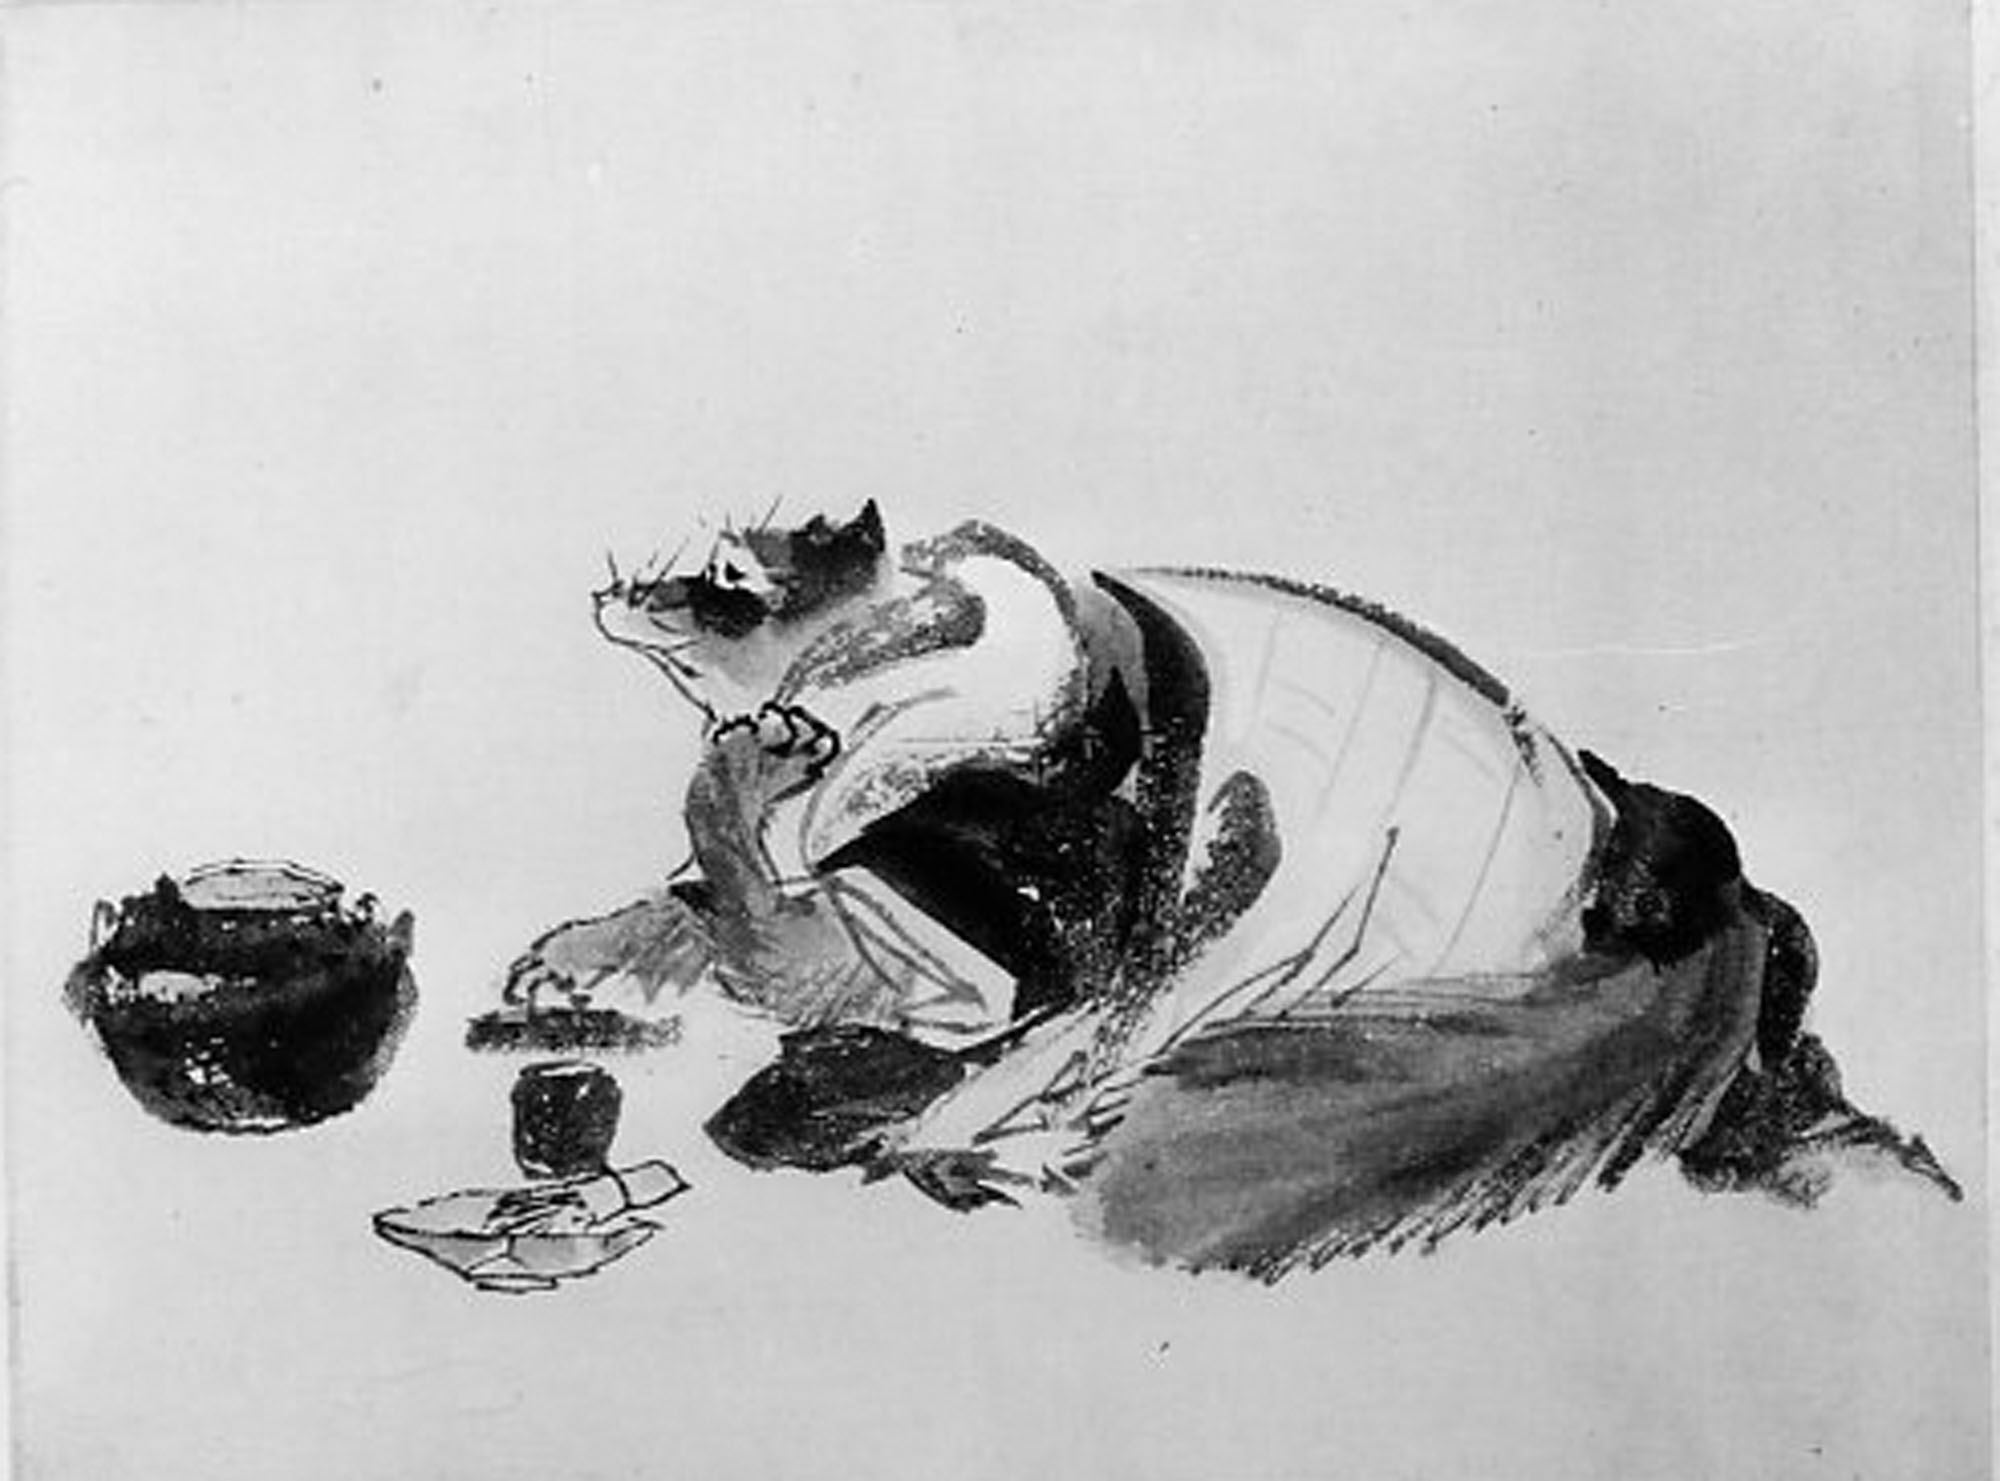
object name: painting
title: Badger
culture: japanese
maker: hokusai school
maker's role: artist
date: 1801-1900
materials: ink, paper, watercolor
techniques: painting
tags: animals